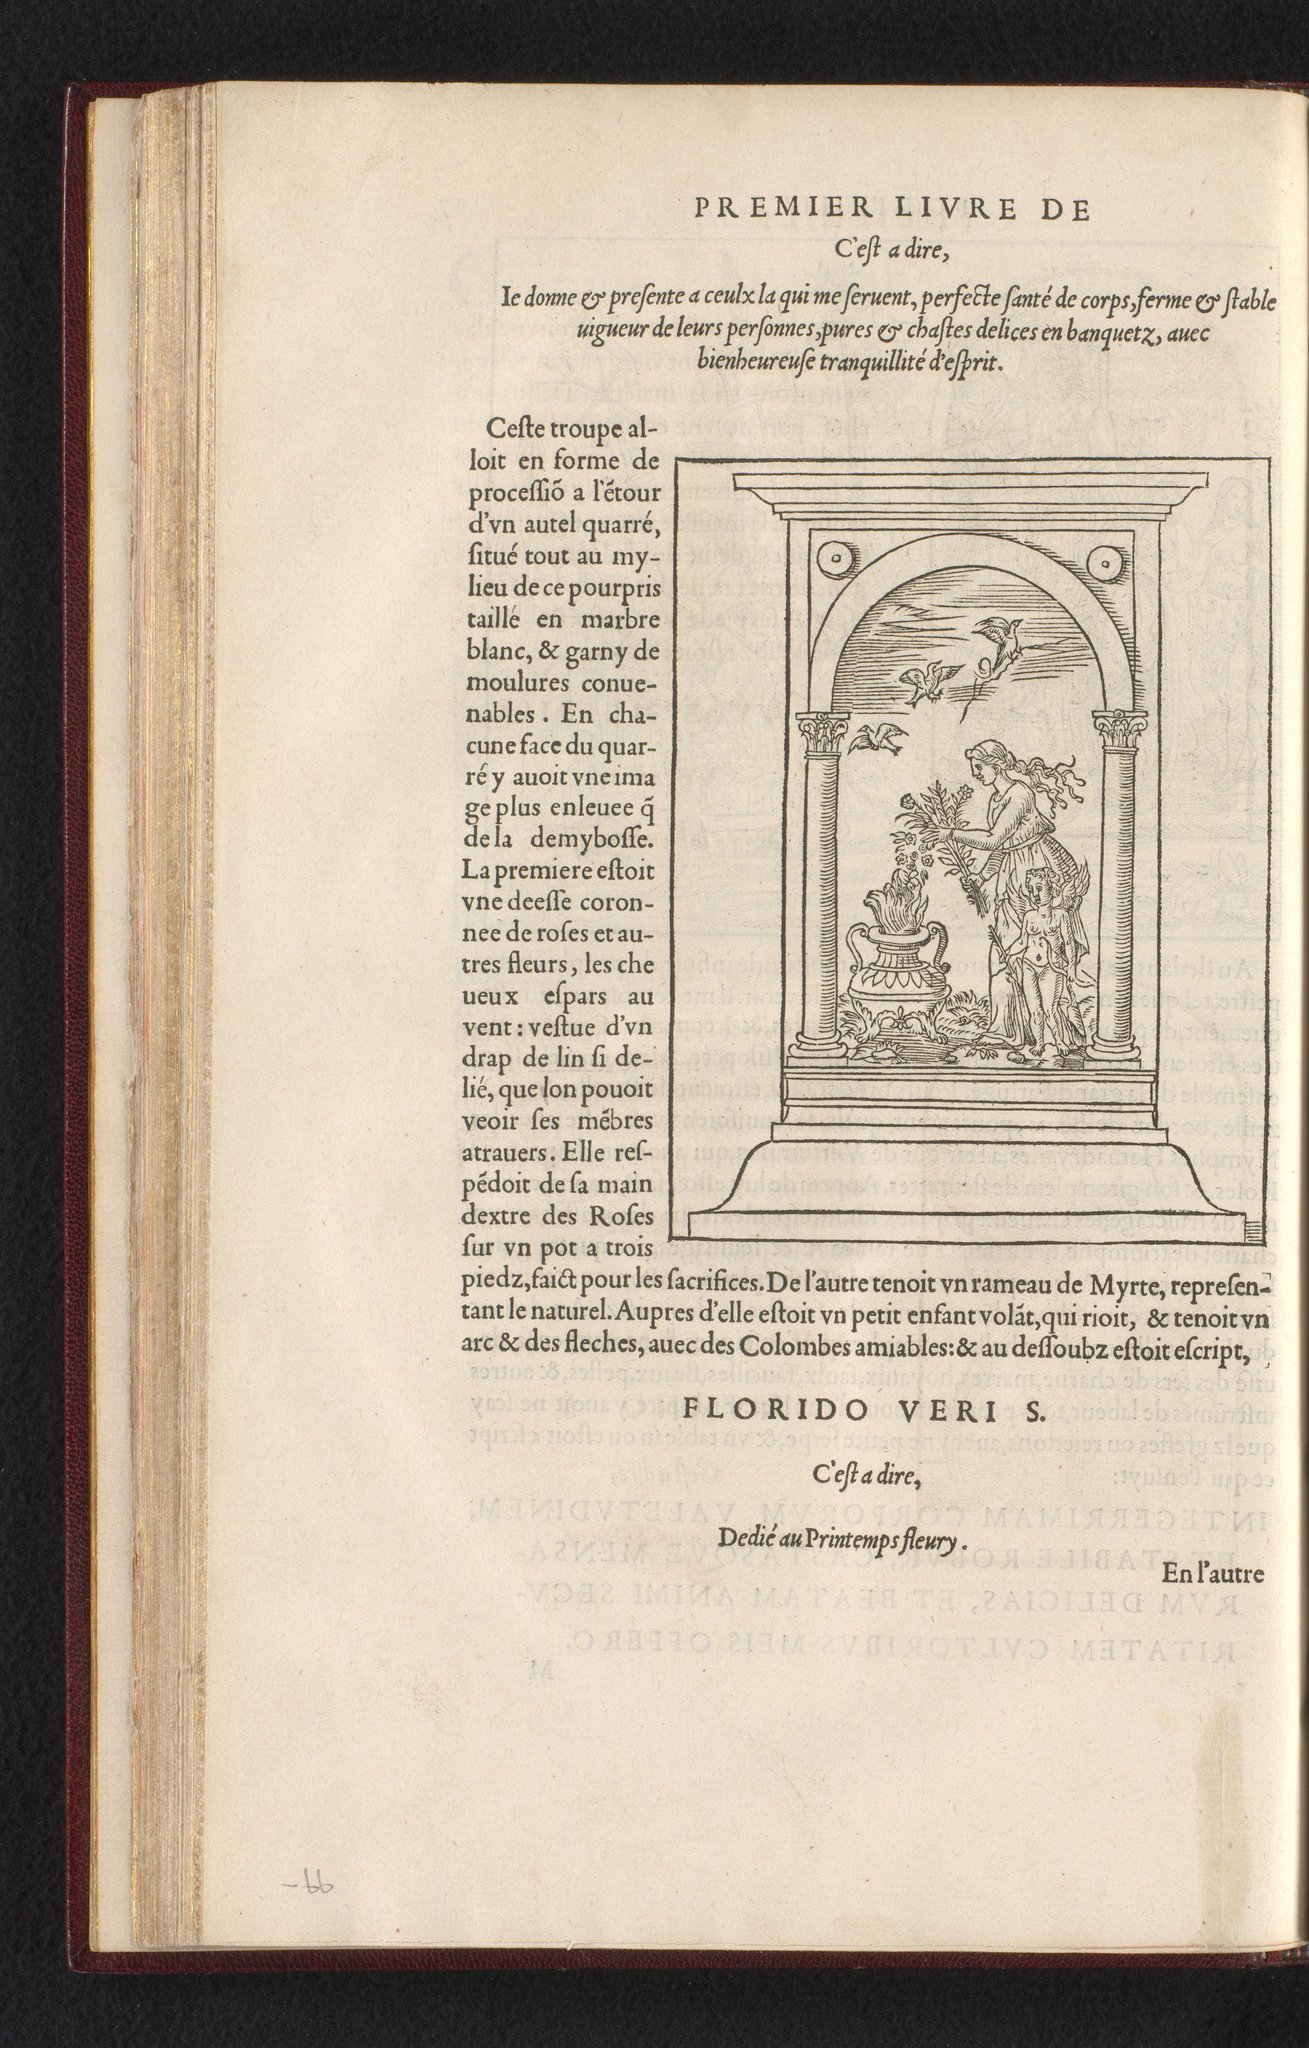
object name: book illustration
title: Vrouw strooit rozenbladen in een vuur, Cupido aan haar zijde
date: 1546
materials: paper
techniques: letterpress printing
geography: paris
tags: (scenes from) specific works of literature: colonna, hypnerotomachia poliphili, bonfire, (story of) cupid, amor (eros), flowers: rose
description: Prent uit: Colonna, Francesco. Hypnerotomachie ou discours du songe de Poliphile, deduisant comme amour le combat a l'occasion de Polia. Parijs: Jacques Kerver, 1546, verso fol. 67.